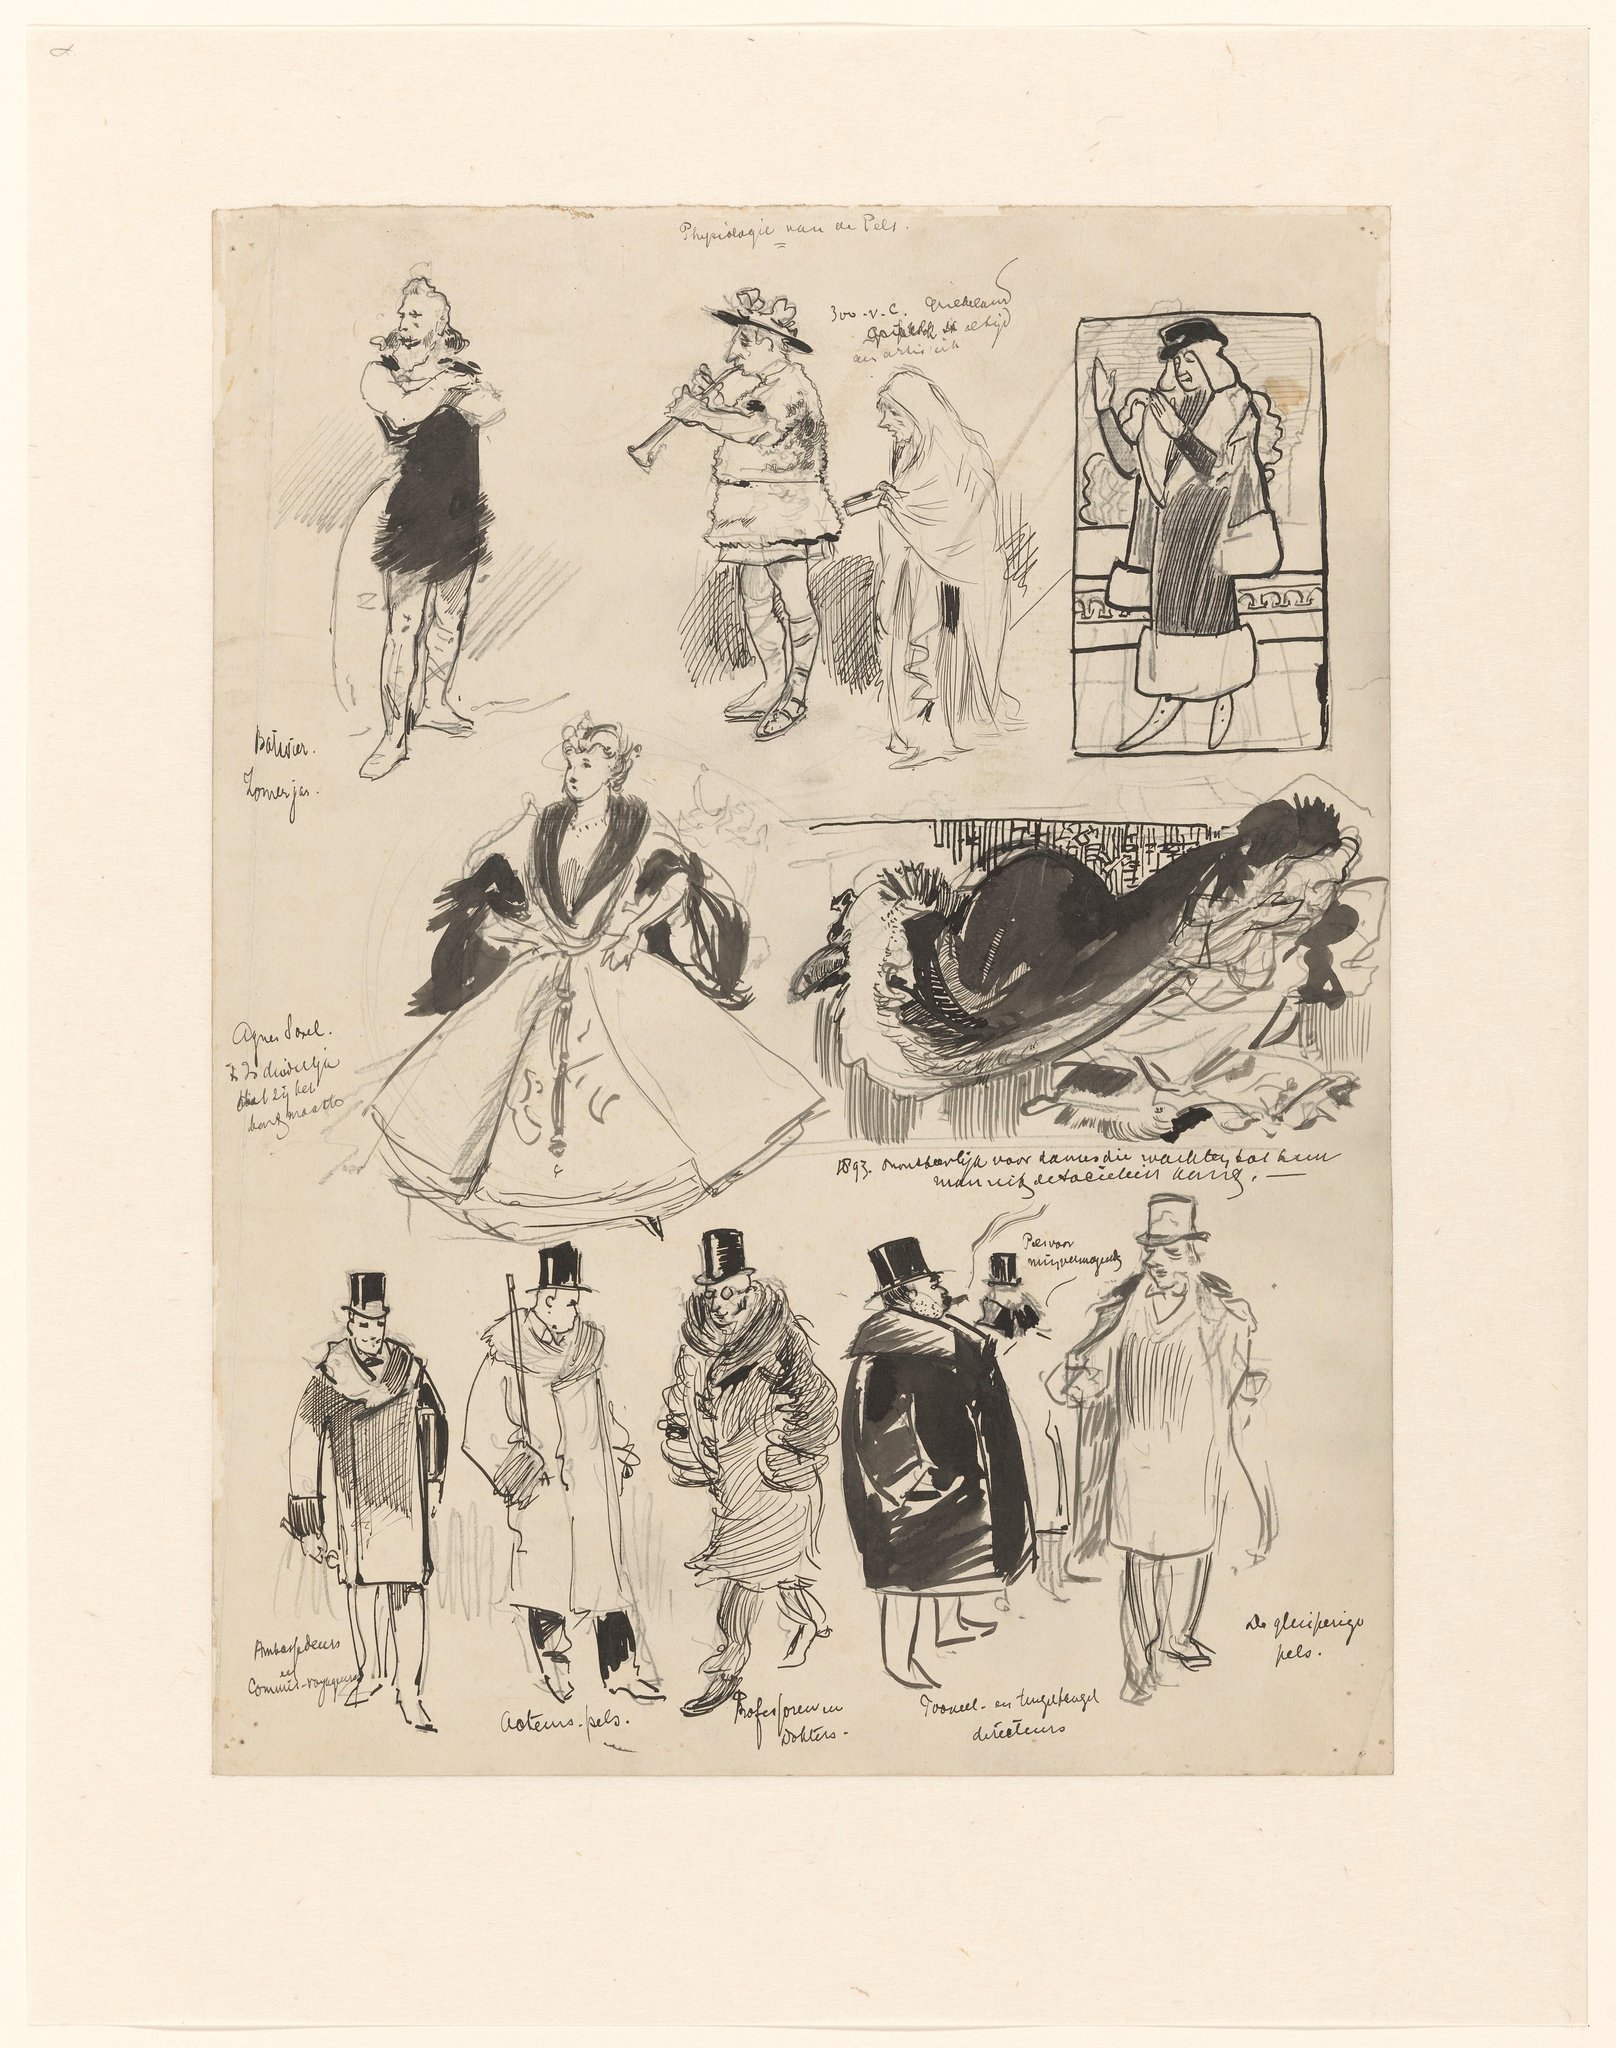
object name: design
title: Physiologie van de Pels: karikaturen op de ontwikkeling van de bontjas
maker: henricus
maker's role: draughtsman, print maker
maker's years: 1867-1921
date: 1877-1921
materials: ink, paper, pencil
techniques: brush, pen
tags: caricatures (human types), coat (+ fur used for clothes), political caricatures and satires